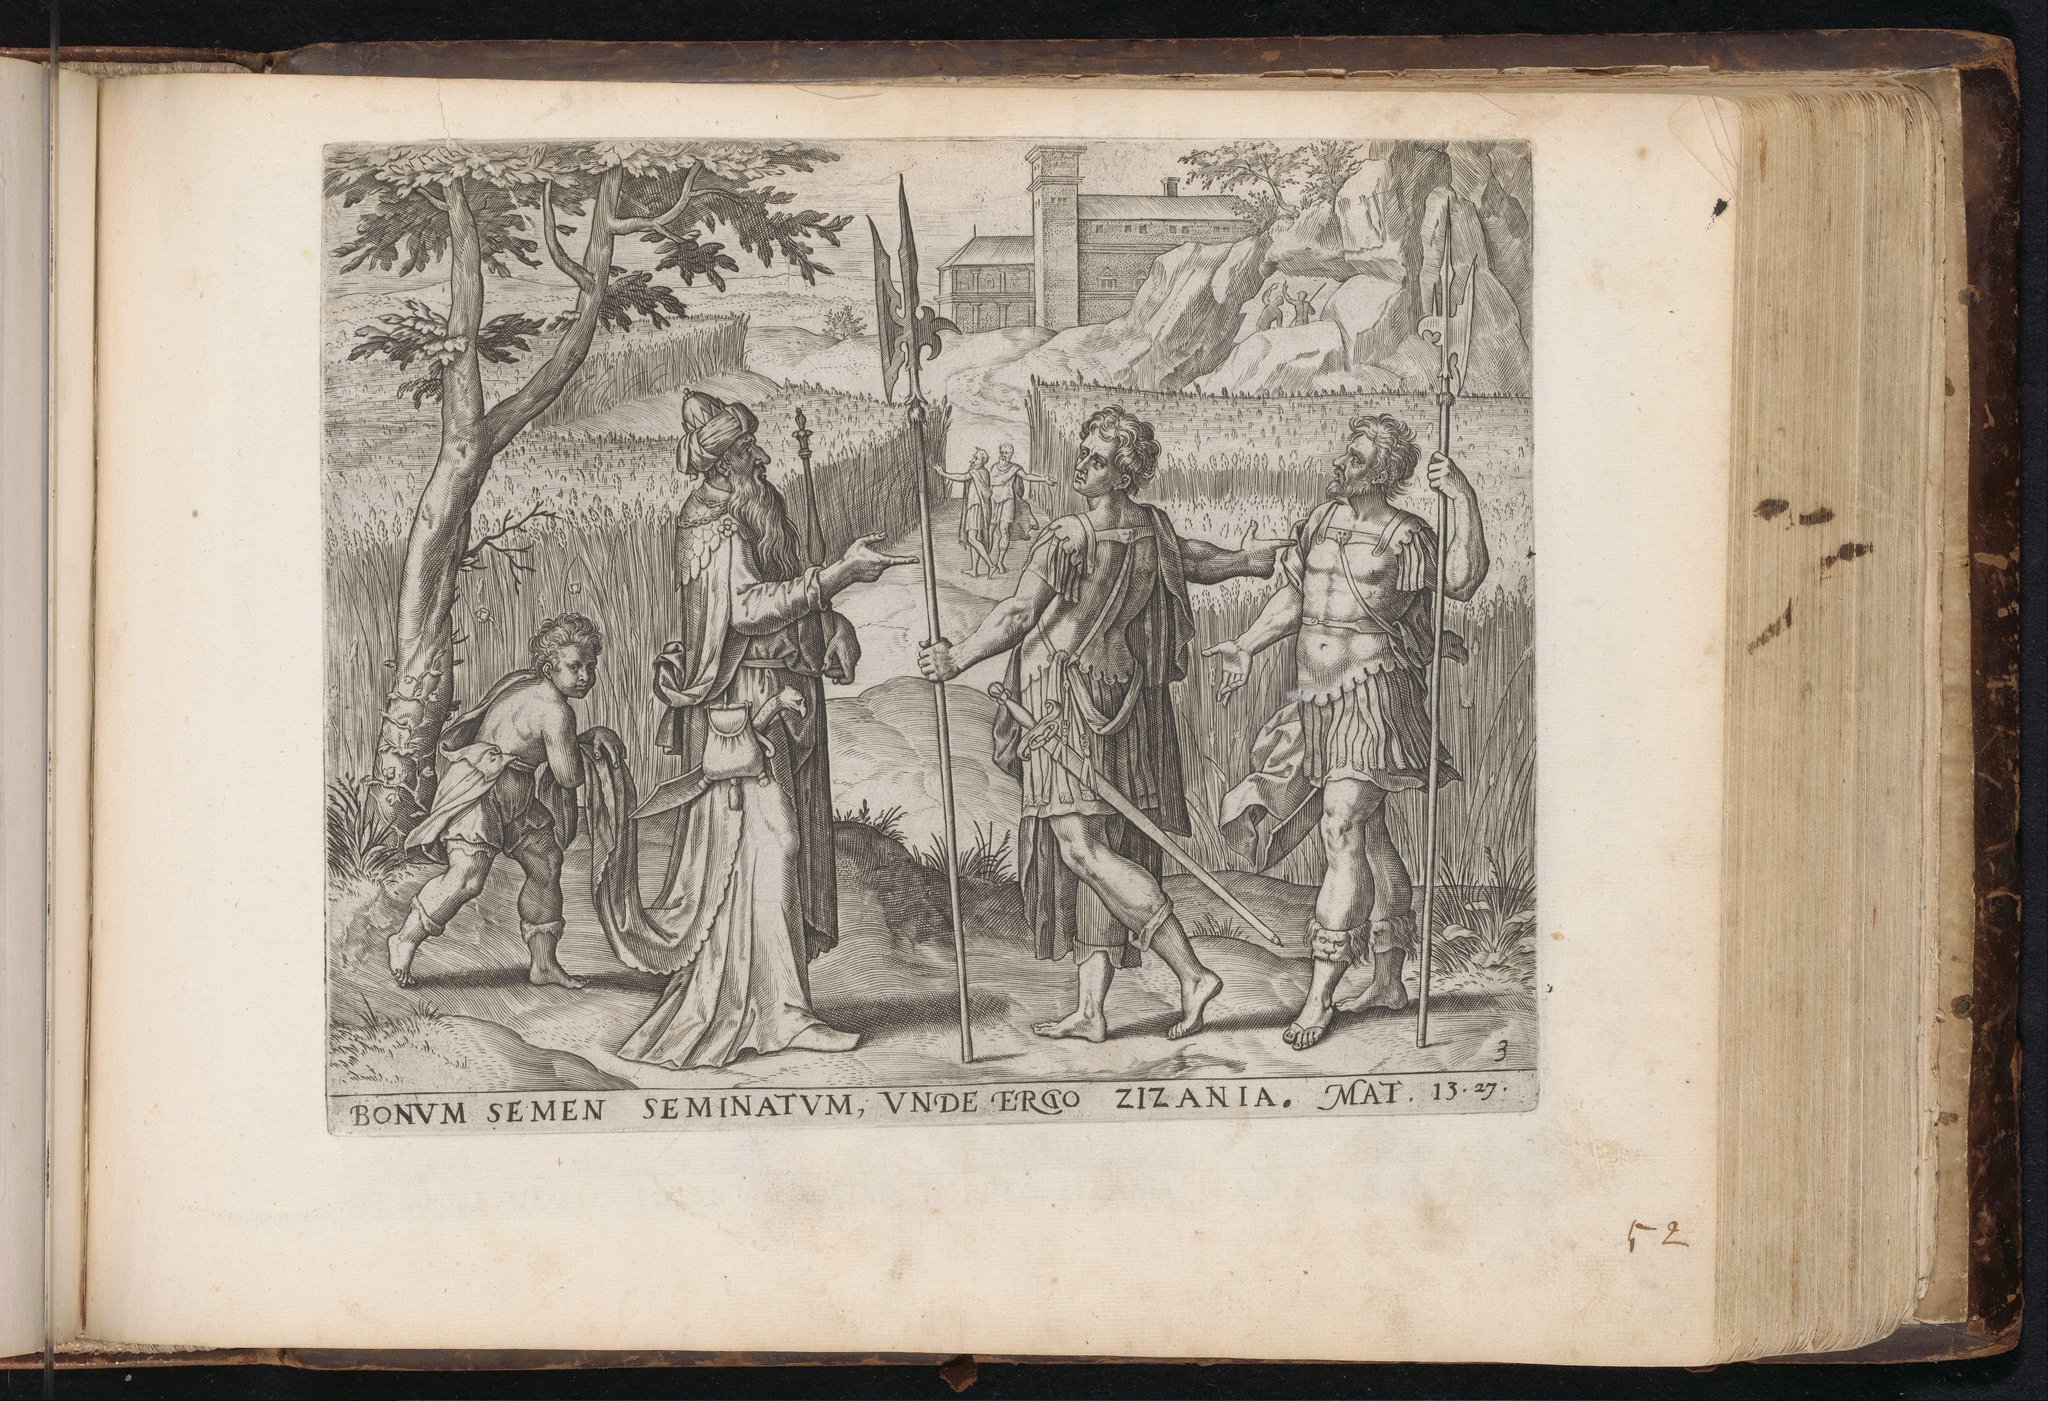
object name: album leaf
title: Gelijkenis van de zaaier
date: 1568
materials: paper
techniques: engraving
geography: alkmaar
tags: a sower sowed good seeds in his field ~ tares among the wheat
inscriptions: number: ‘52’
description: De knechten, beiden met een hellebaard in de hand, vragen aan de landheer of zij het onkruid tussen het graan moeten wieden. De landheer geeft als antwoord dat het graan en het onkruid moeten blijven groeien tot aan de oogst. Een jongen houdt het kleed van de landheer vast. Onder de voorstelling een verwijzing in het Latijn naar de Bijbeltekst in Mat. 13:27. Deze prent maakt deel uit van een album.